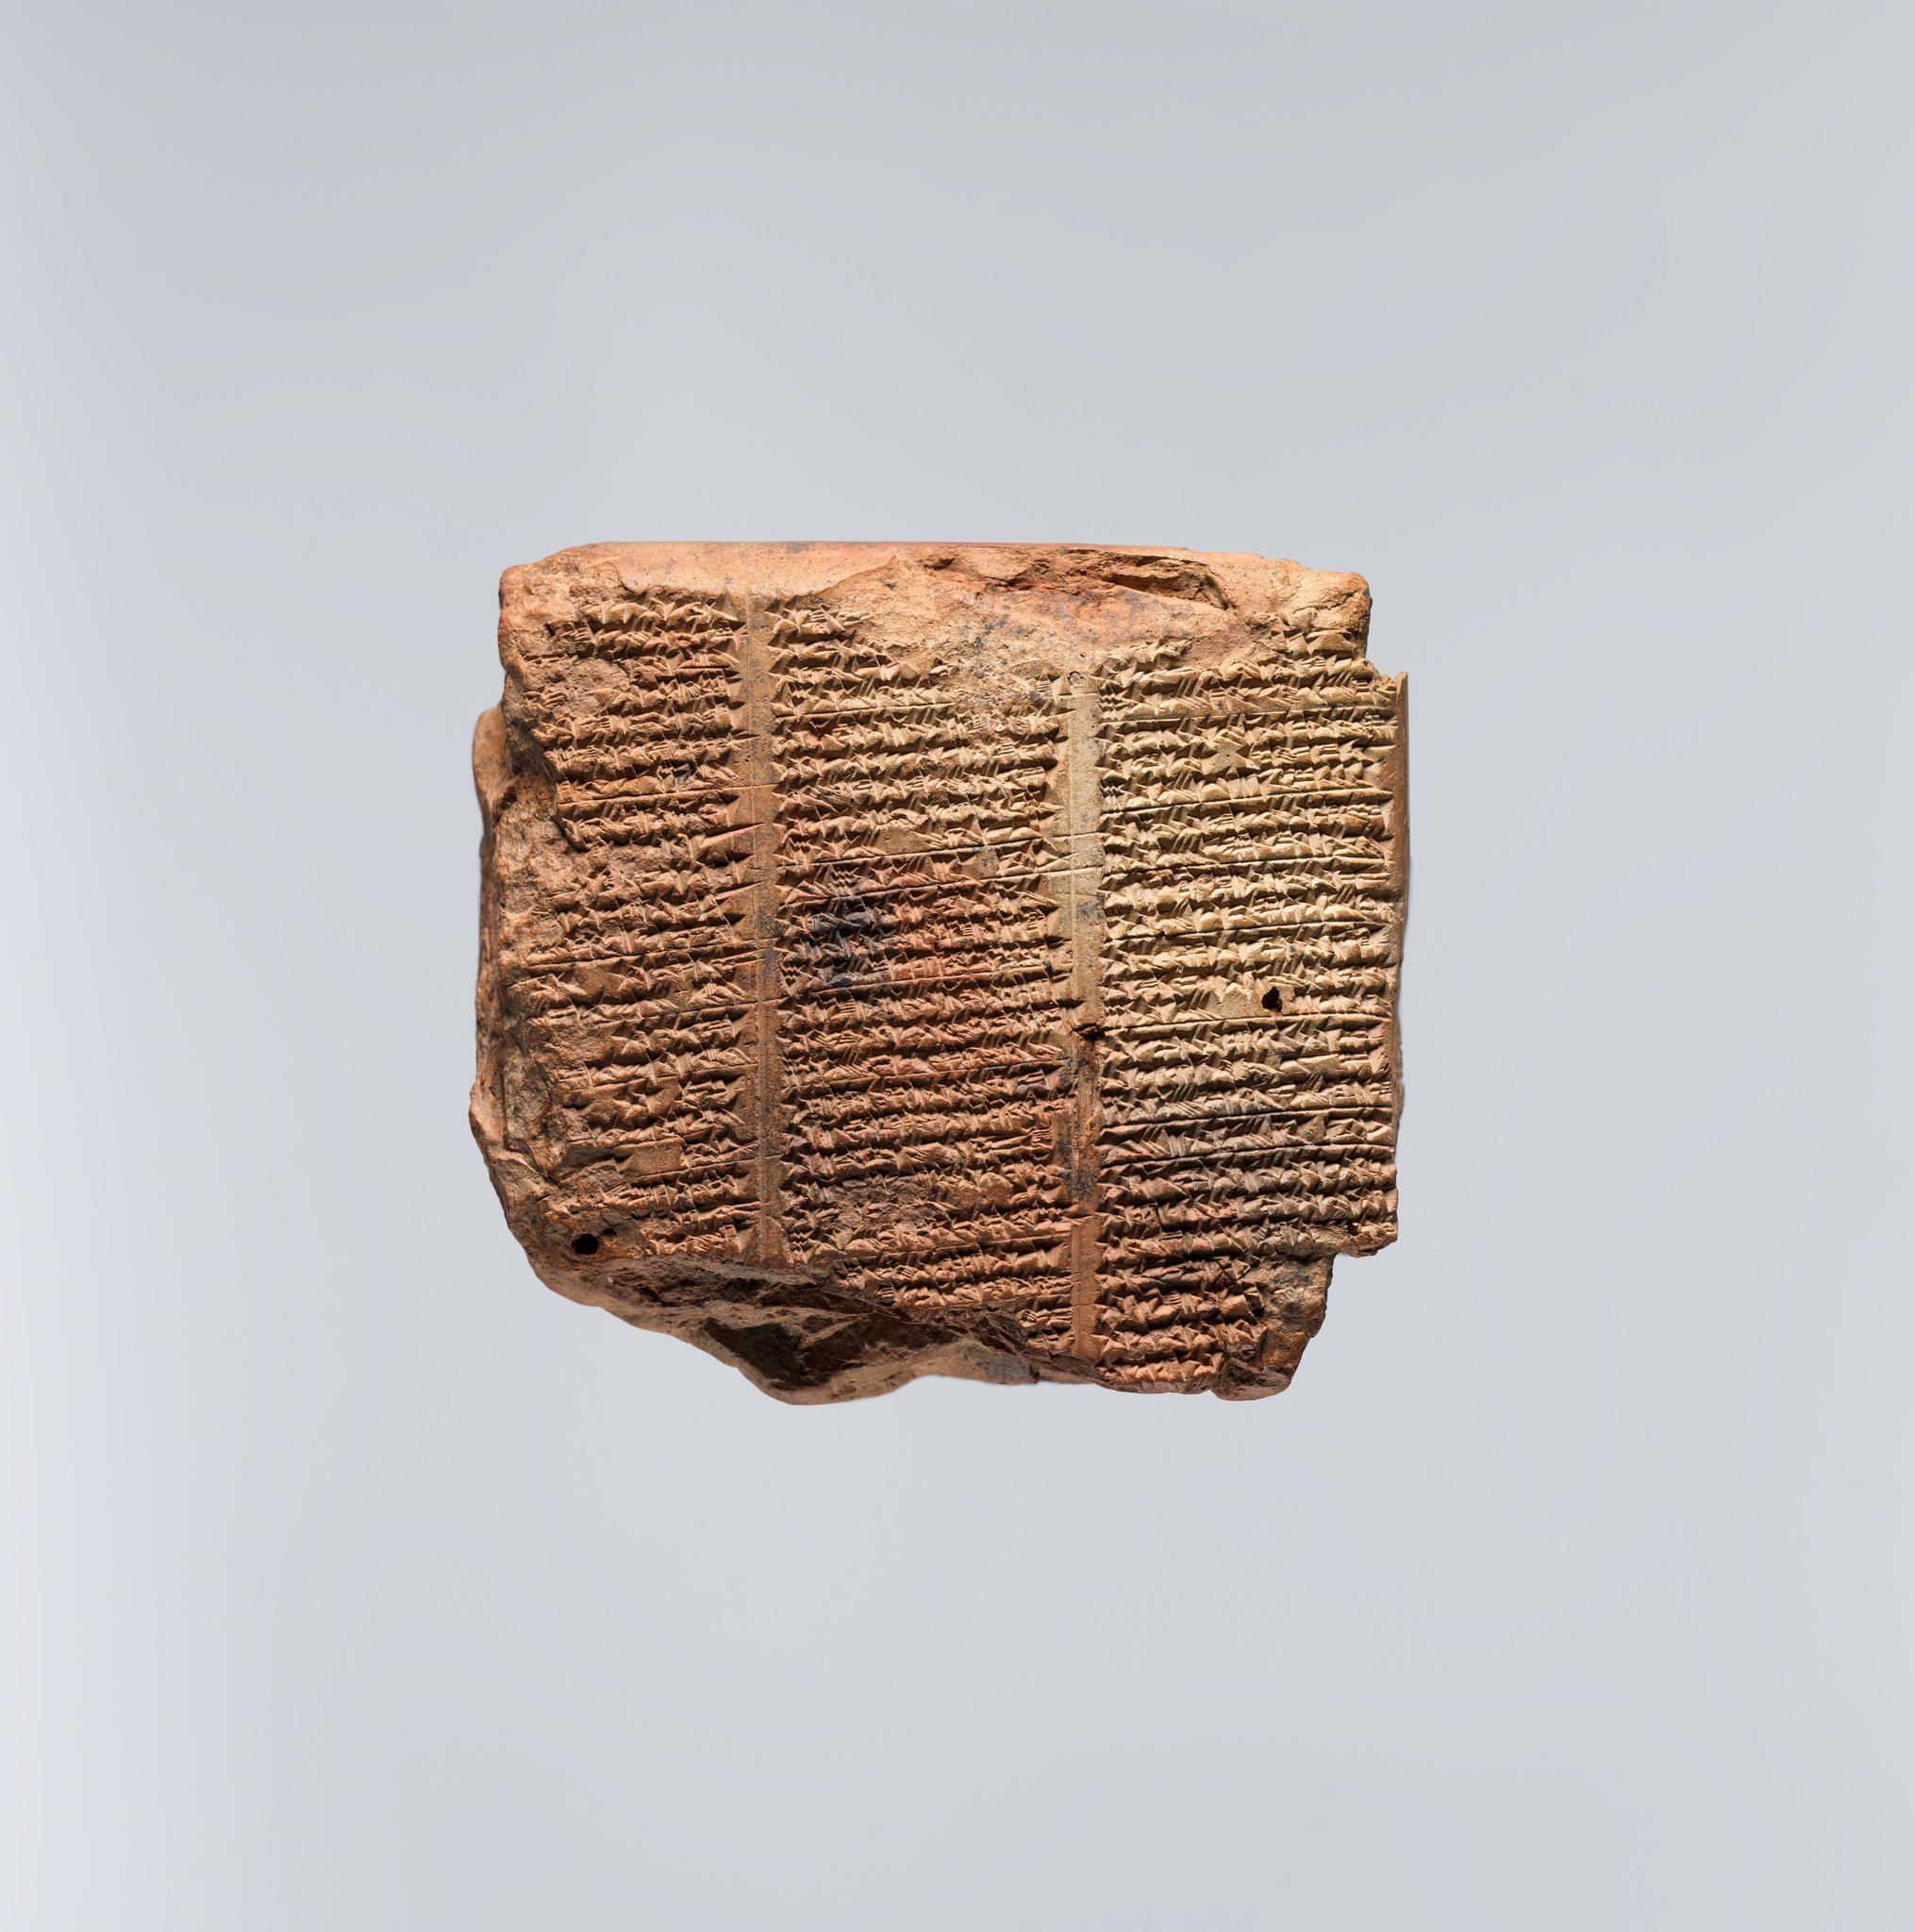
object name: cuneiform tablet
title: Cuneiform tablet: list of magical stones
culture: achaemenid or seleucid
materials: clay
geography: mesopotamia